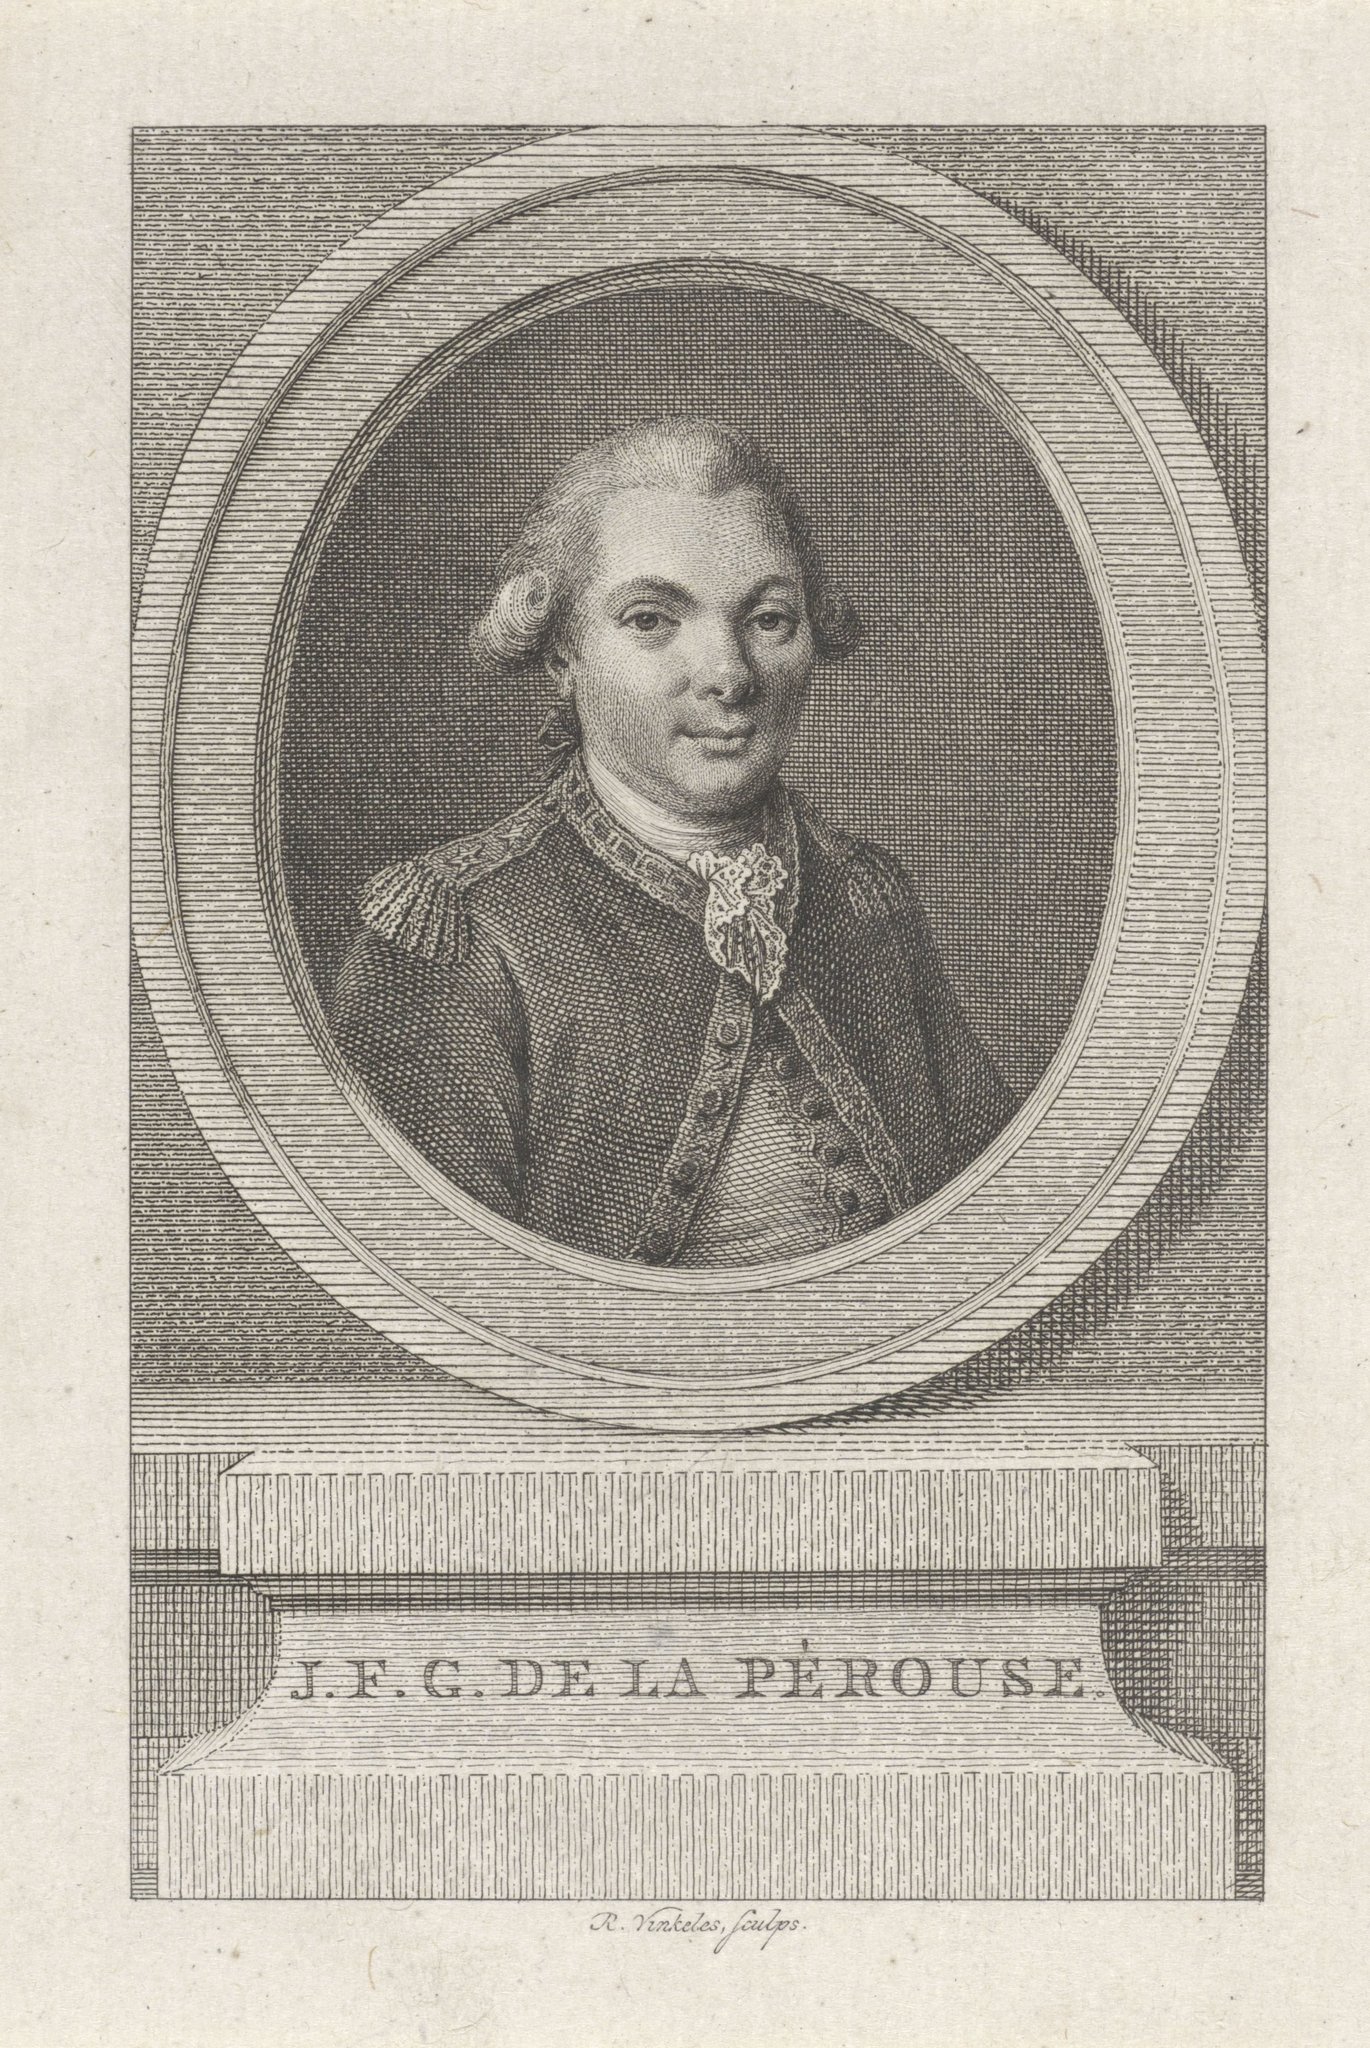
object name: print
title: Portret van Jean-François de La Pérouse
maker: reinier vinkeles (i)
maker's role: draughtsman, print maker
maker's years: 1741-1816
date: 1785-1816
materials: paper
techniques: engraving, etching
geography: amsterdam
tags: albi, officier, ontdekkingsreiziger, jean-françois de la pérouse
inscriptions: collector's mark: Lugt 2228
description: Portret van Jean-François de La Pérouse, Frans marine-officier en ontdekkingsreiziger.